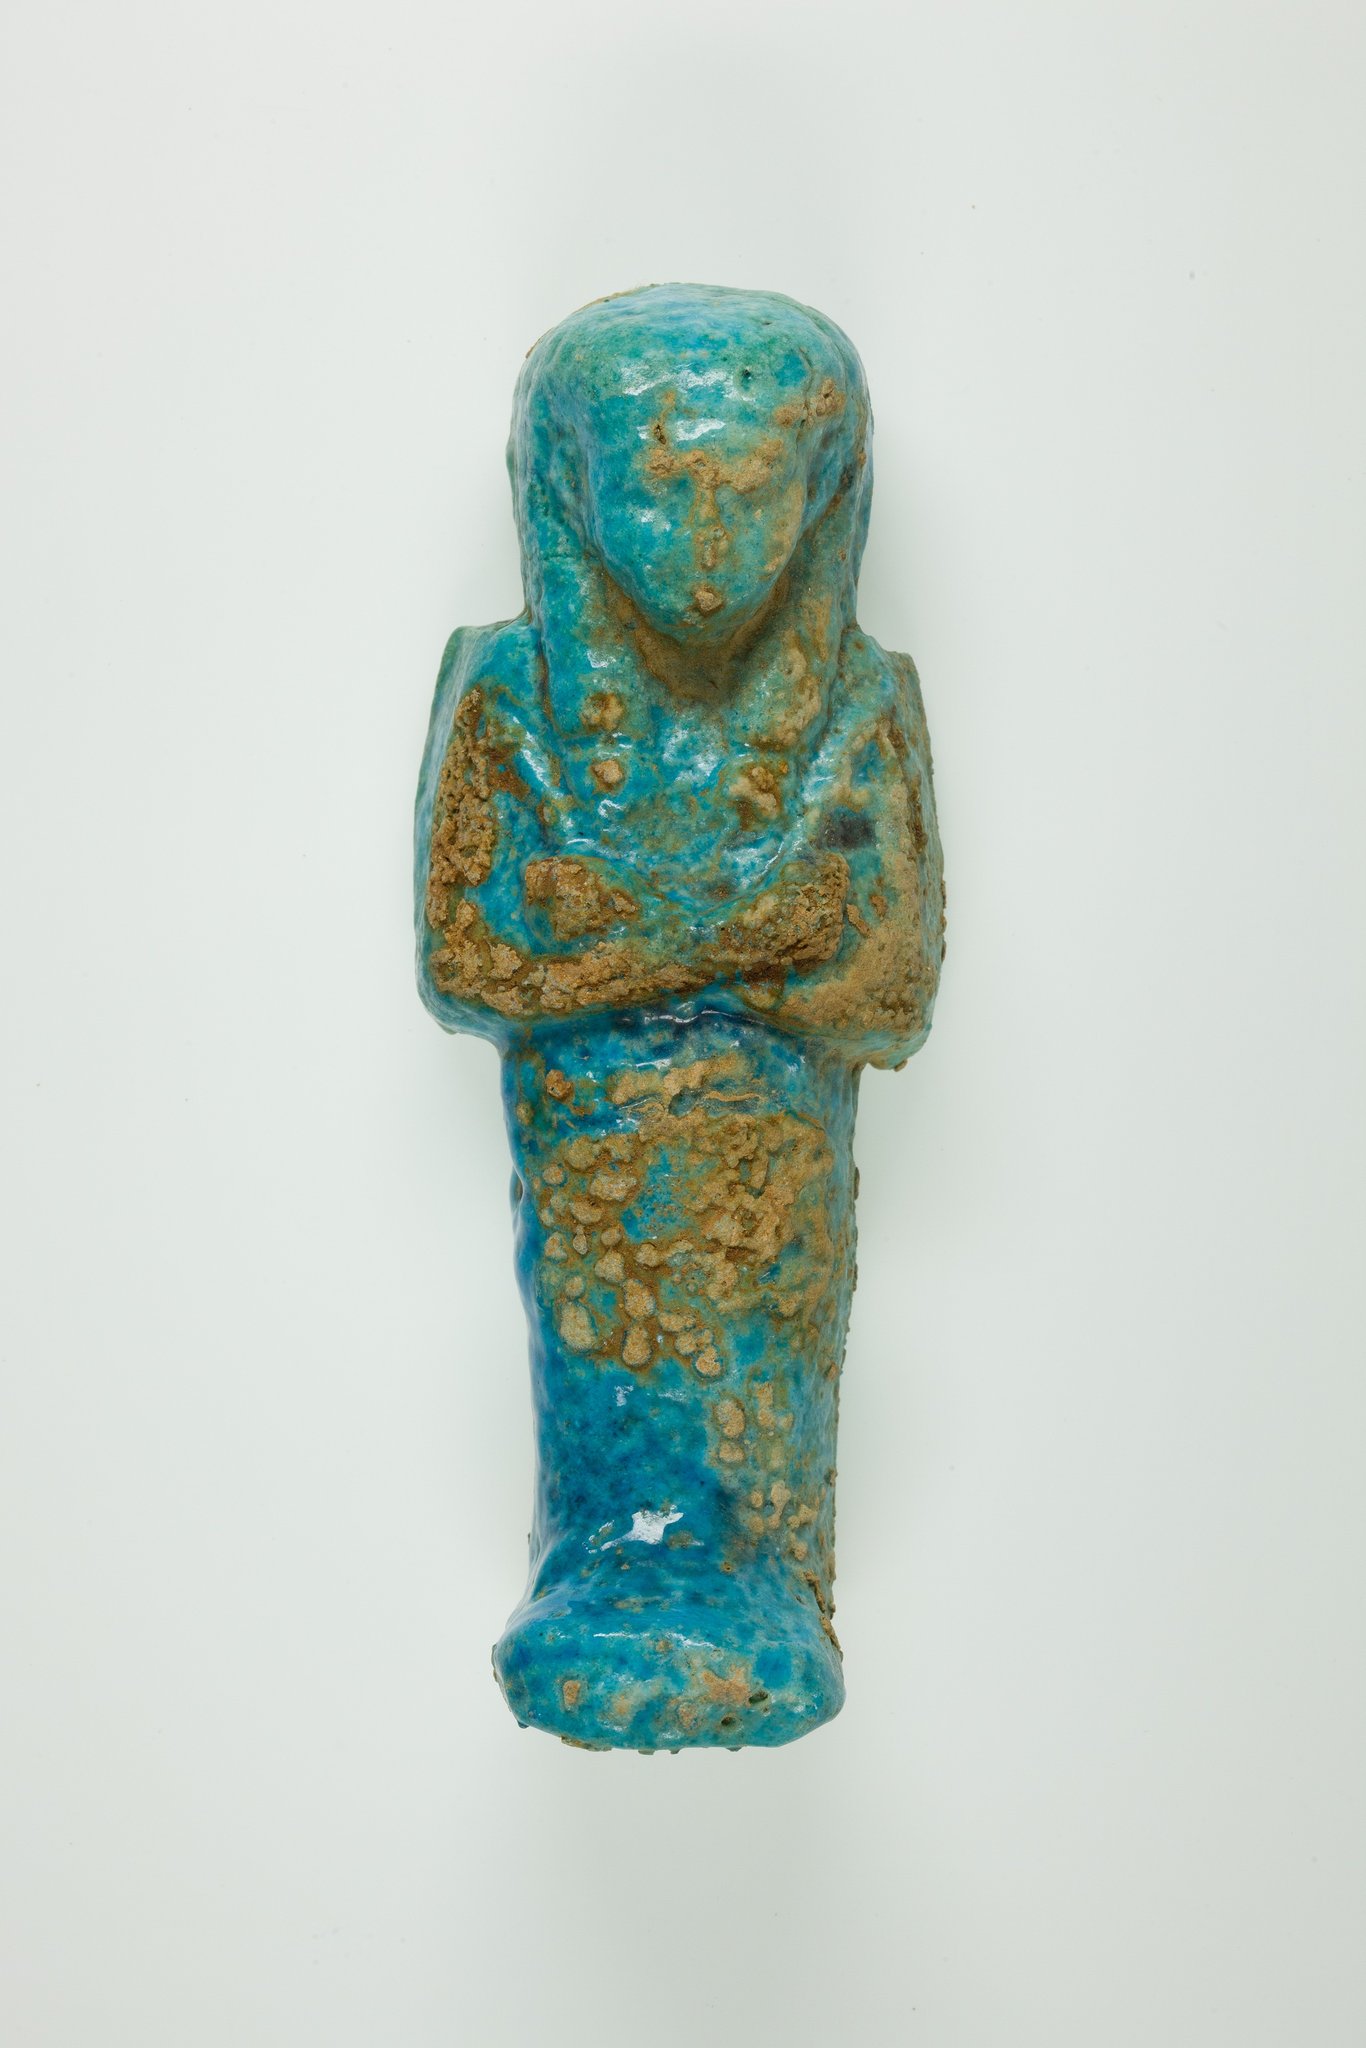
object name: worker shabti, henettawy c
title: Worker Shabti of Henettawy (C), Daughter of Isetemkheb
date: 990-970 BCE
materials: faience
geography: egypt